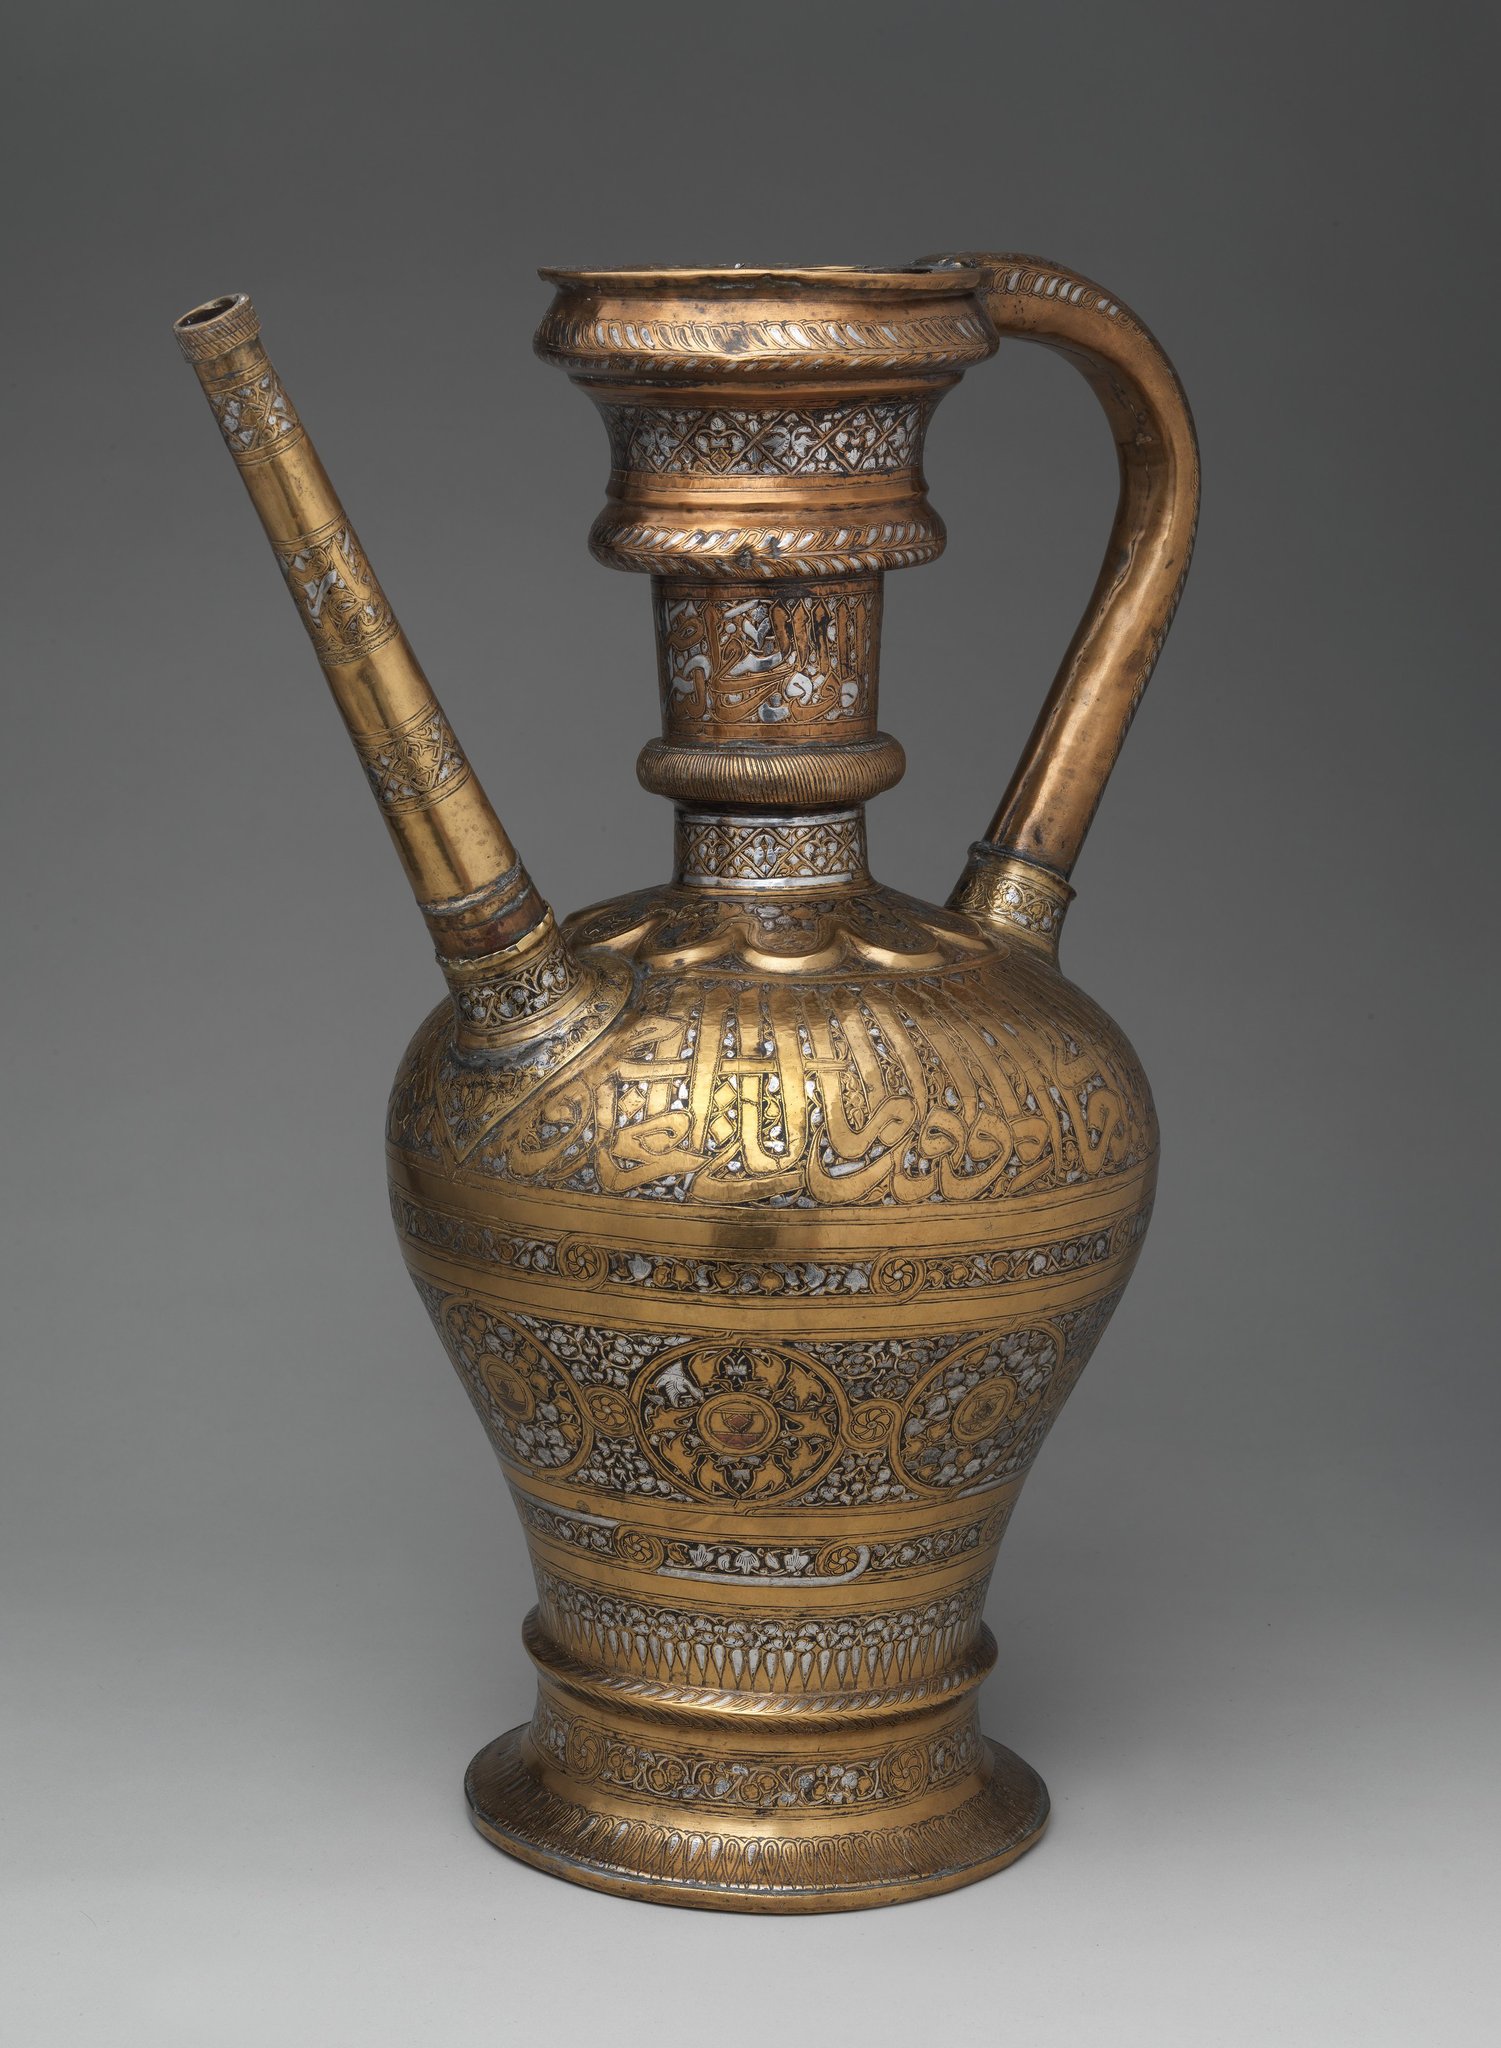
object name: ewer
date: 1301-1350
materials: brass, copper, silver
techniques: engraving, inlay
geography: egypt